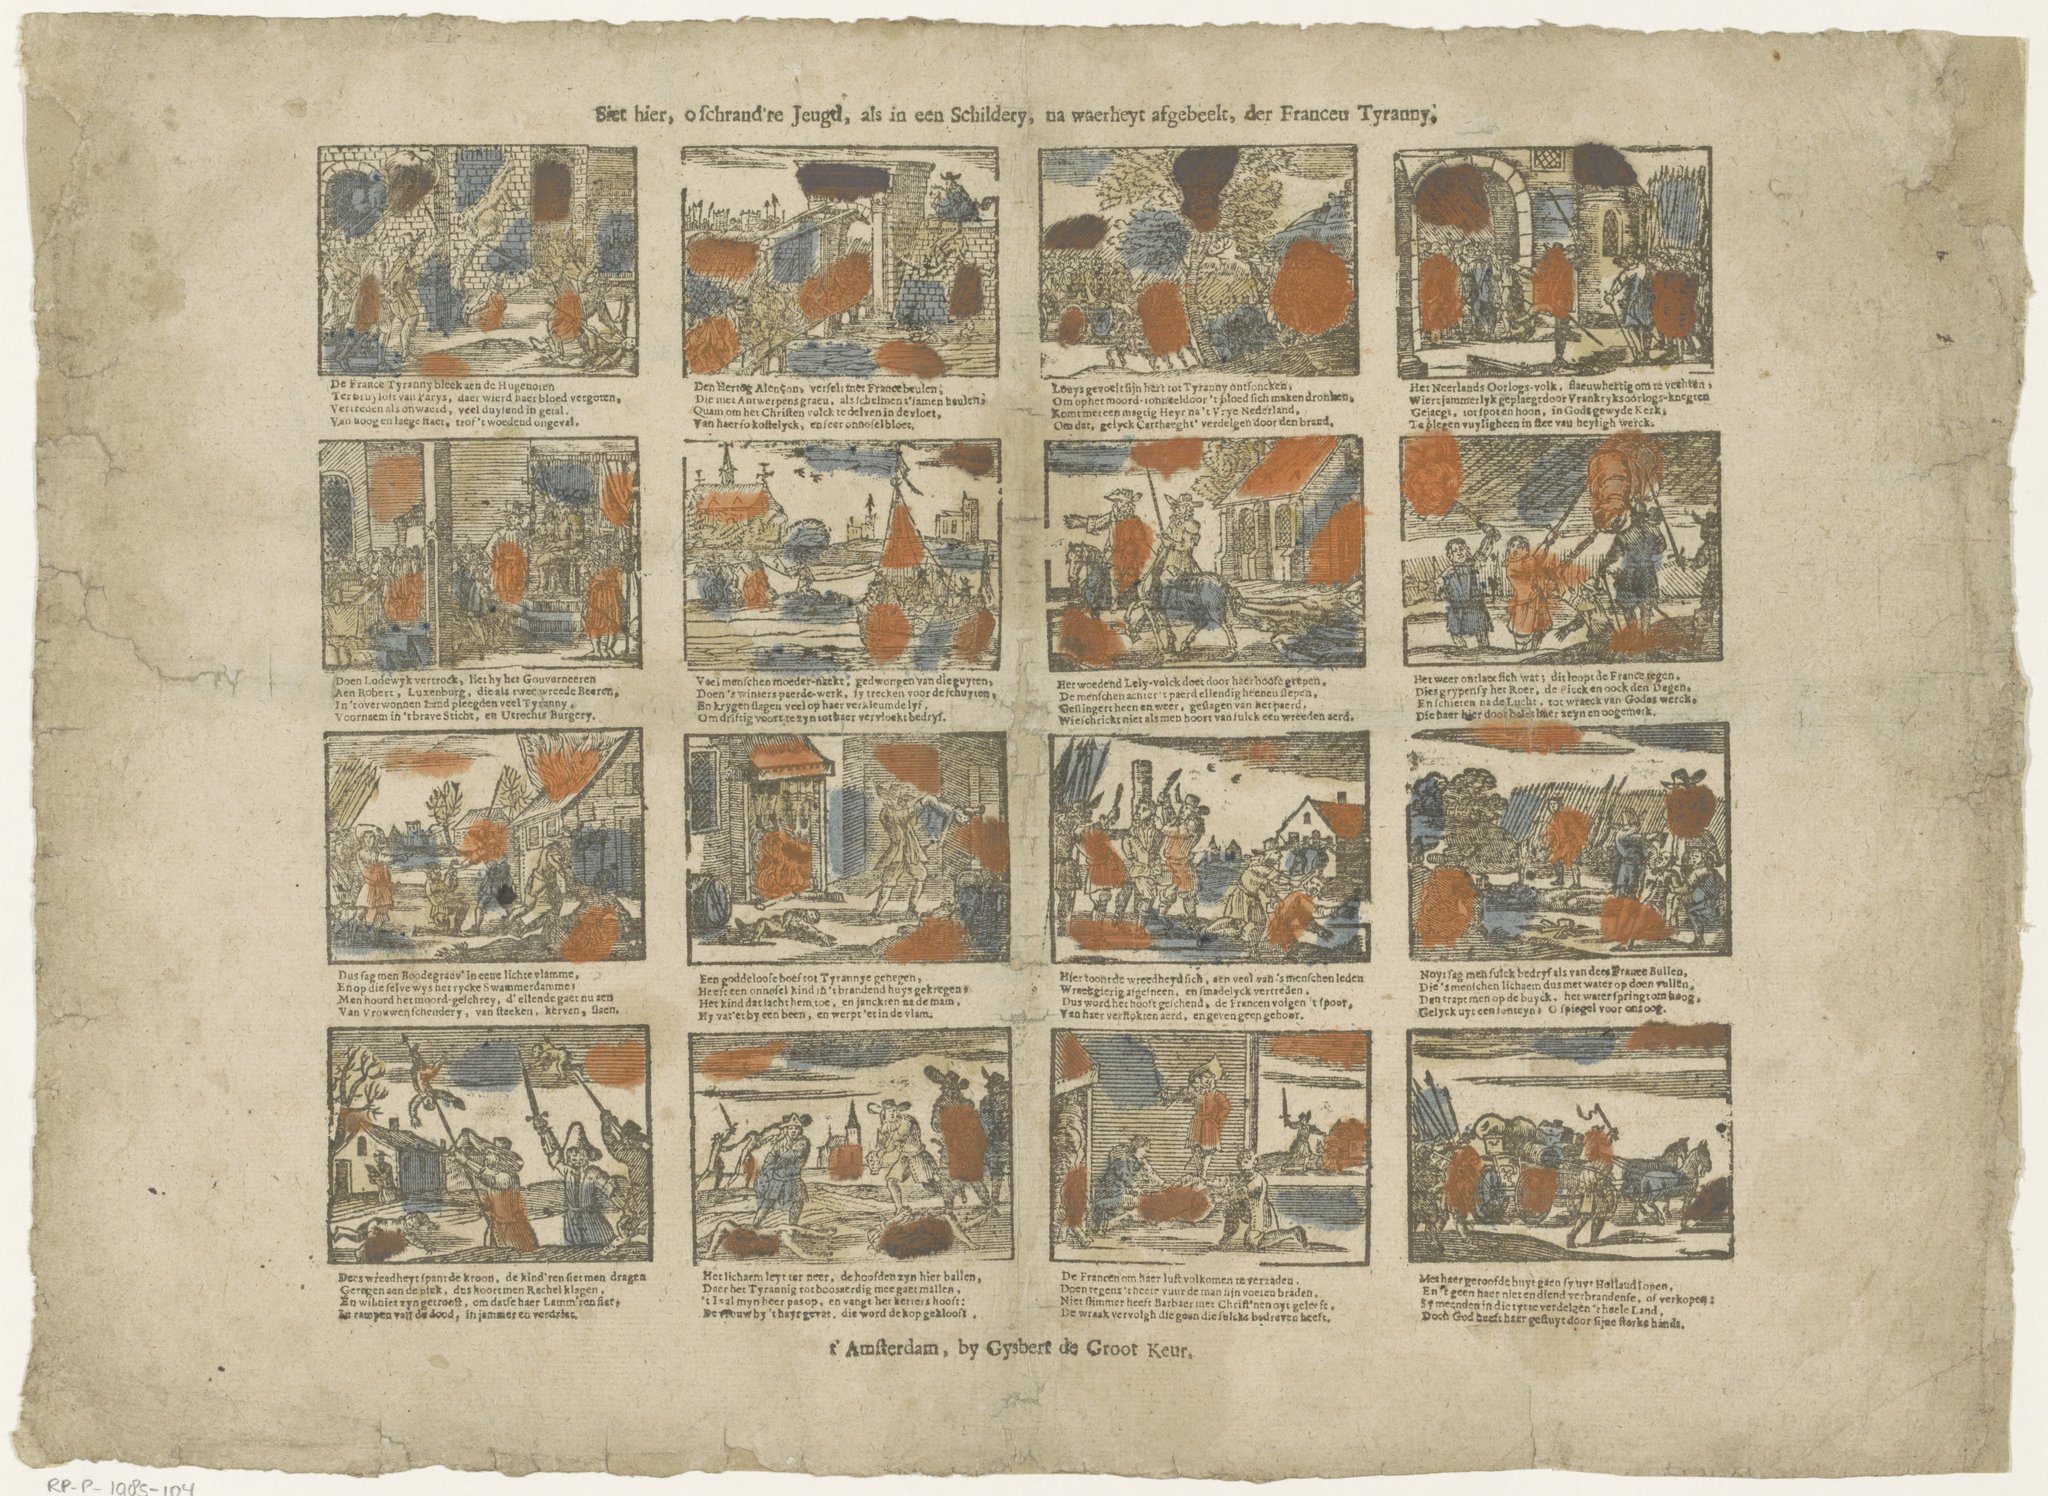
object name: print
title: Siet hier, o schrand're jeugd, als in een schildery, na waerheyt afgebeeldt, der Franceu Tyranny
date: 1738-1767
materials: paper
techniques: colour, letterpress printing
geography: amsterdam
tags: governmental systems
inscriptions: collector's mark: Lugt 2228, collector's mark: Lugt 2760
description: Blad met 16 voorstellingen van de Franse tyrannie. Onder elke voorstelling een vierregelig vers.